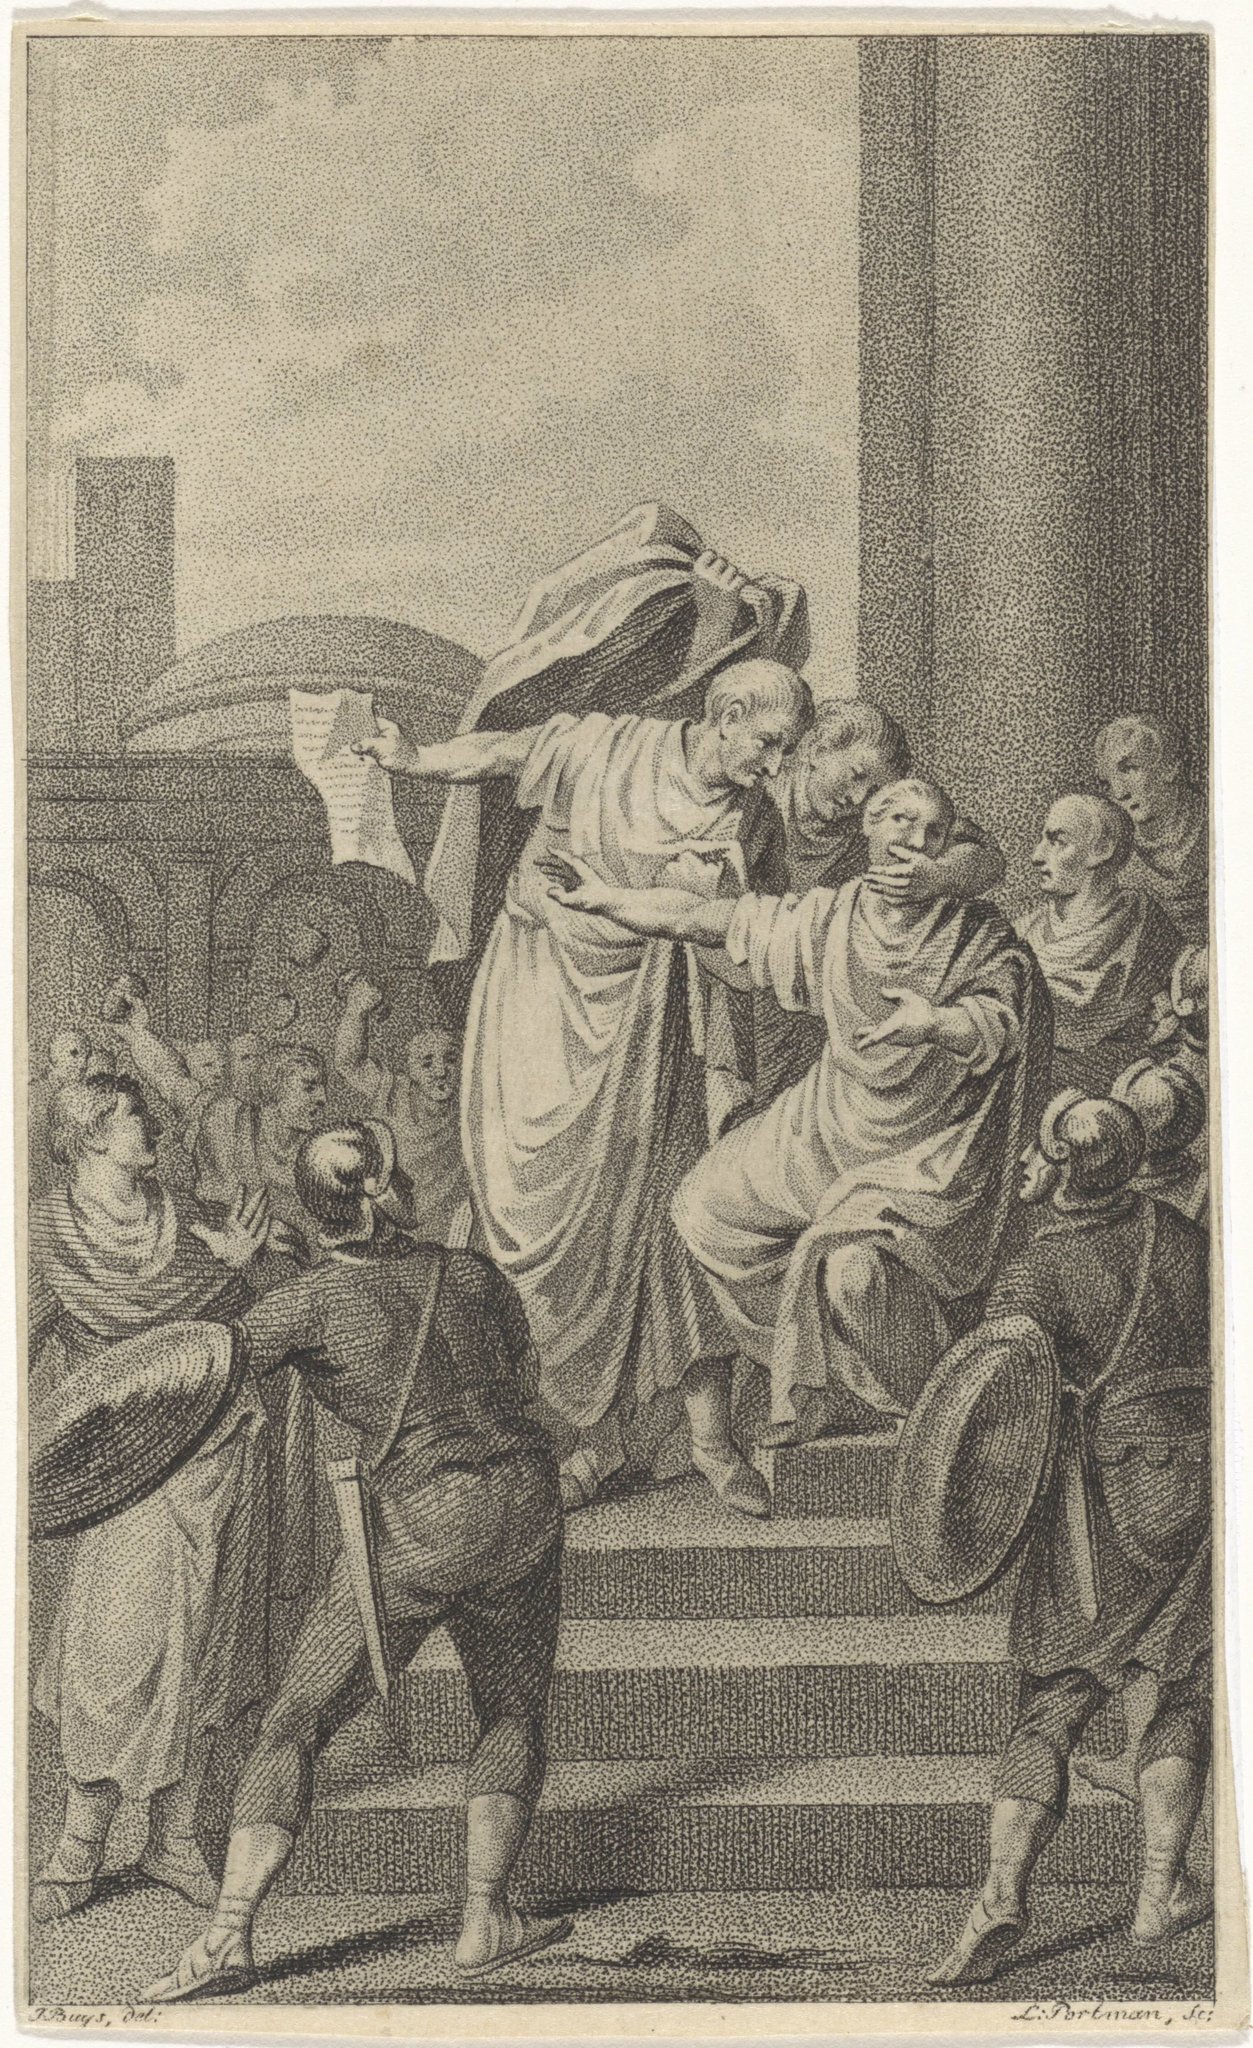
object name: print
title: Cato's verzet tegen Metellus Nepos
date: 1799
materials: paper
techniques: etching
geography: amsterdam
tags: (story of) marcus porcius cato the younger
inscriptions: collector's mark: Lugt 2228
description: Op de trappen van de tempel van Castor zit Metellus, vergezeld door Caesar. Marcus Porcius Cato de Jongere stormt de trappen op en komt tussen beide. Cato grist de brief uit de handen van Metellus en Thermus houdt zijn hand voor diens mond om hem het spreken te beletten.